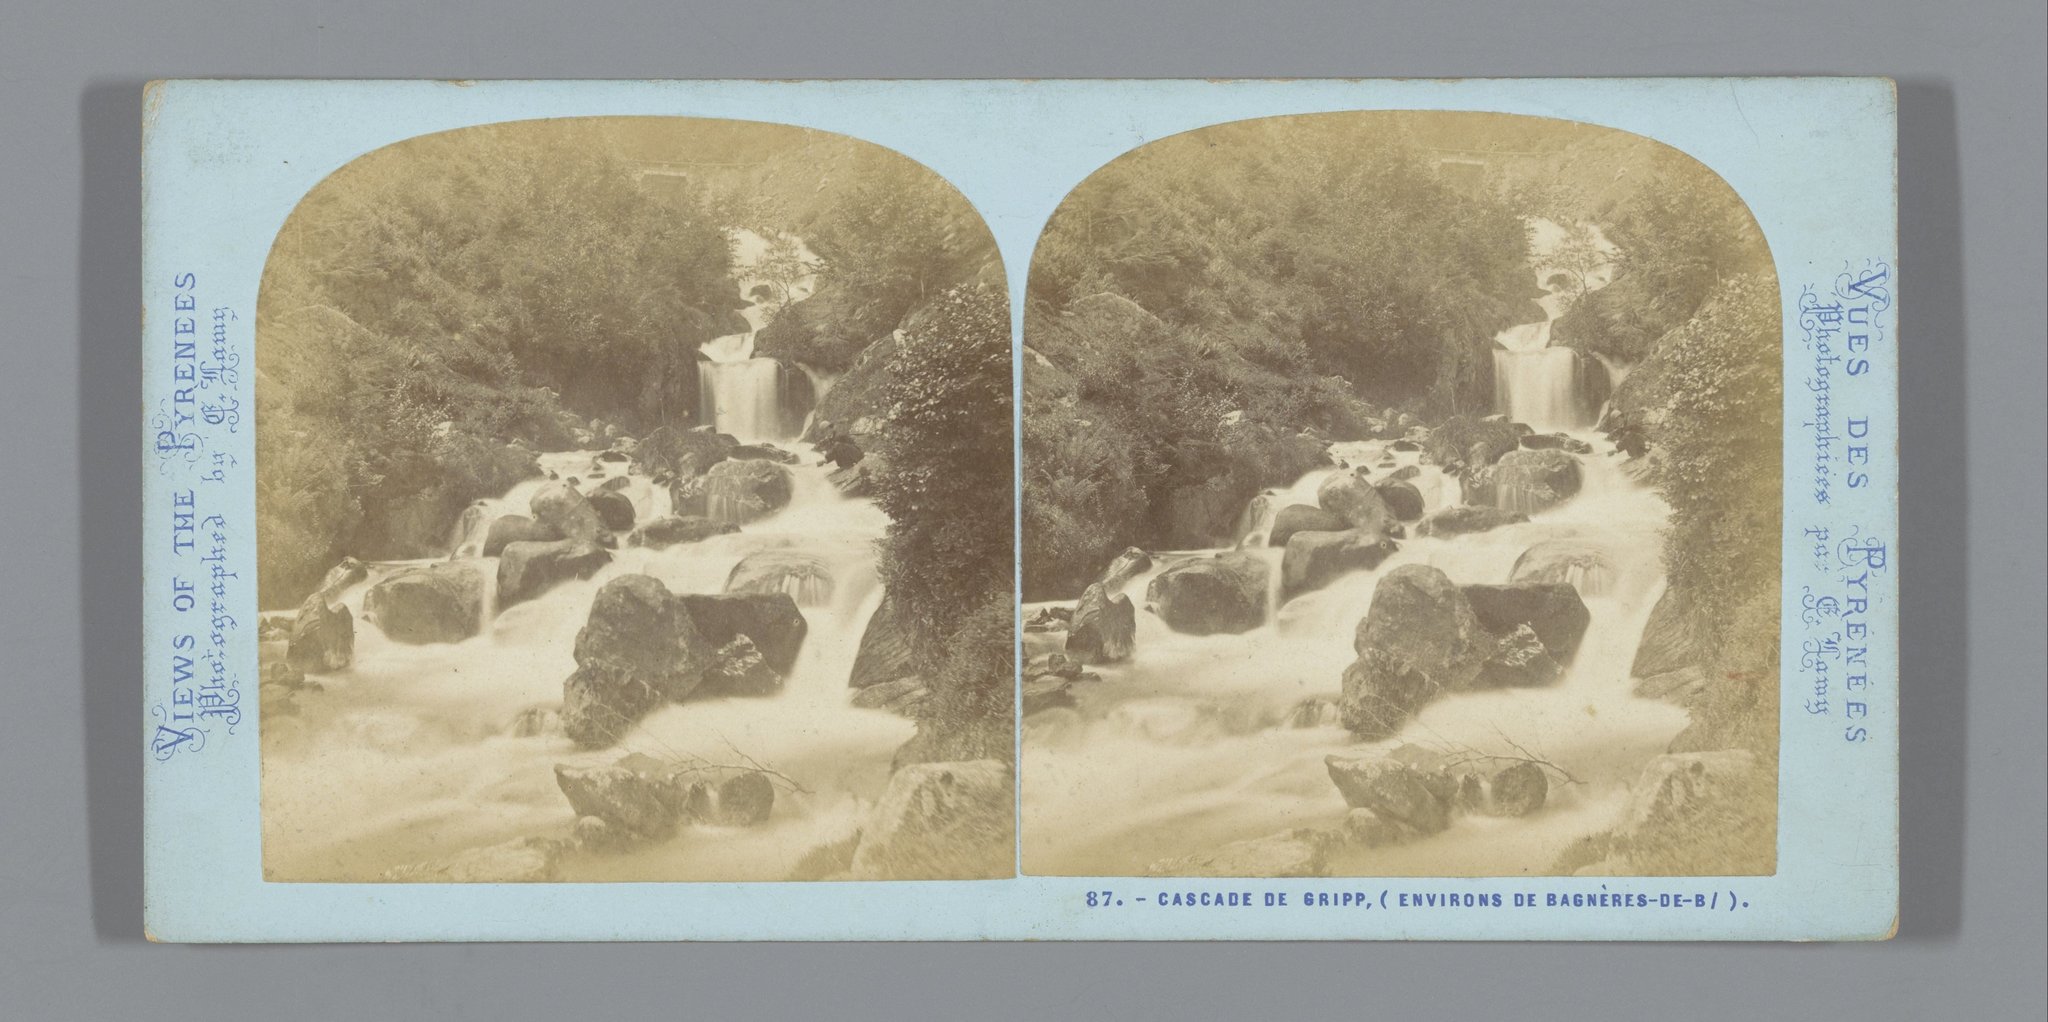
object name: stereograph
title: Stroomversnelling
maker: ernest eléonor pierre lamy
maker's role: publisher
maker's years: 1828-1900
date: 1860-1880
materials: cardboard, photographic support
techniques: photography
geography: pyrenees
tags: rapids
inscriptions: number: ‘87.’